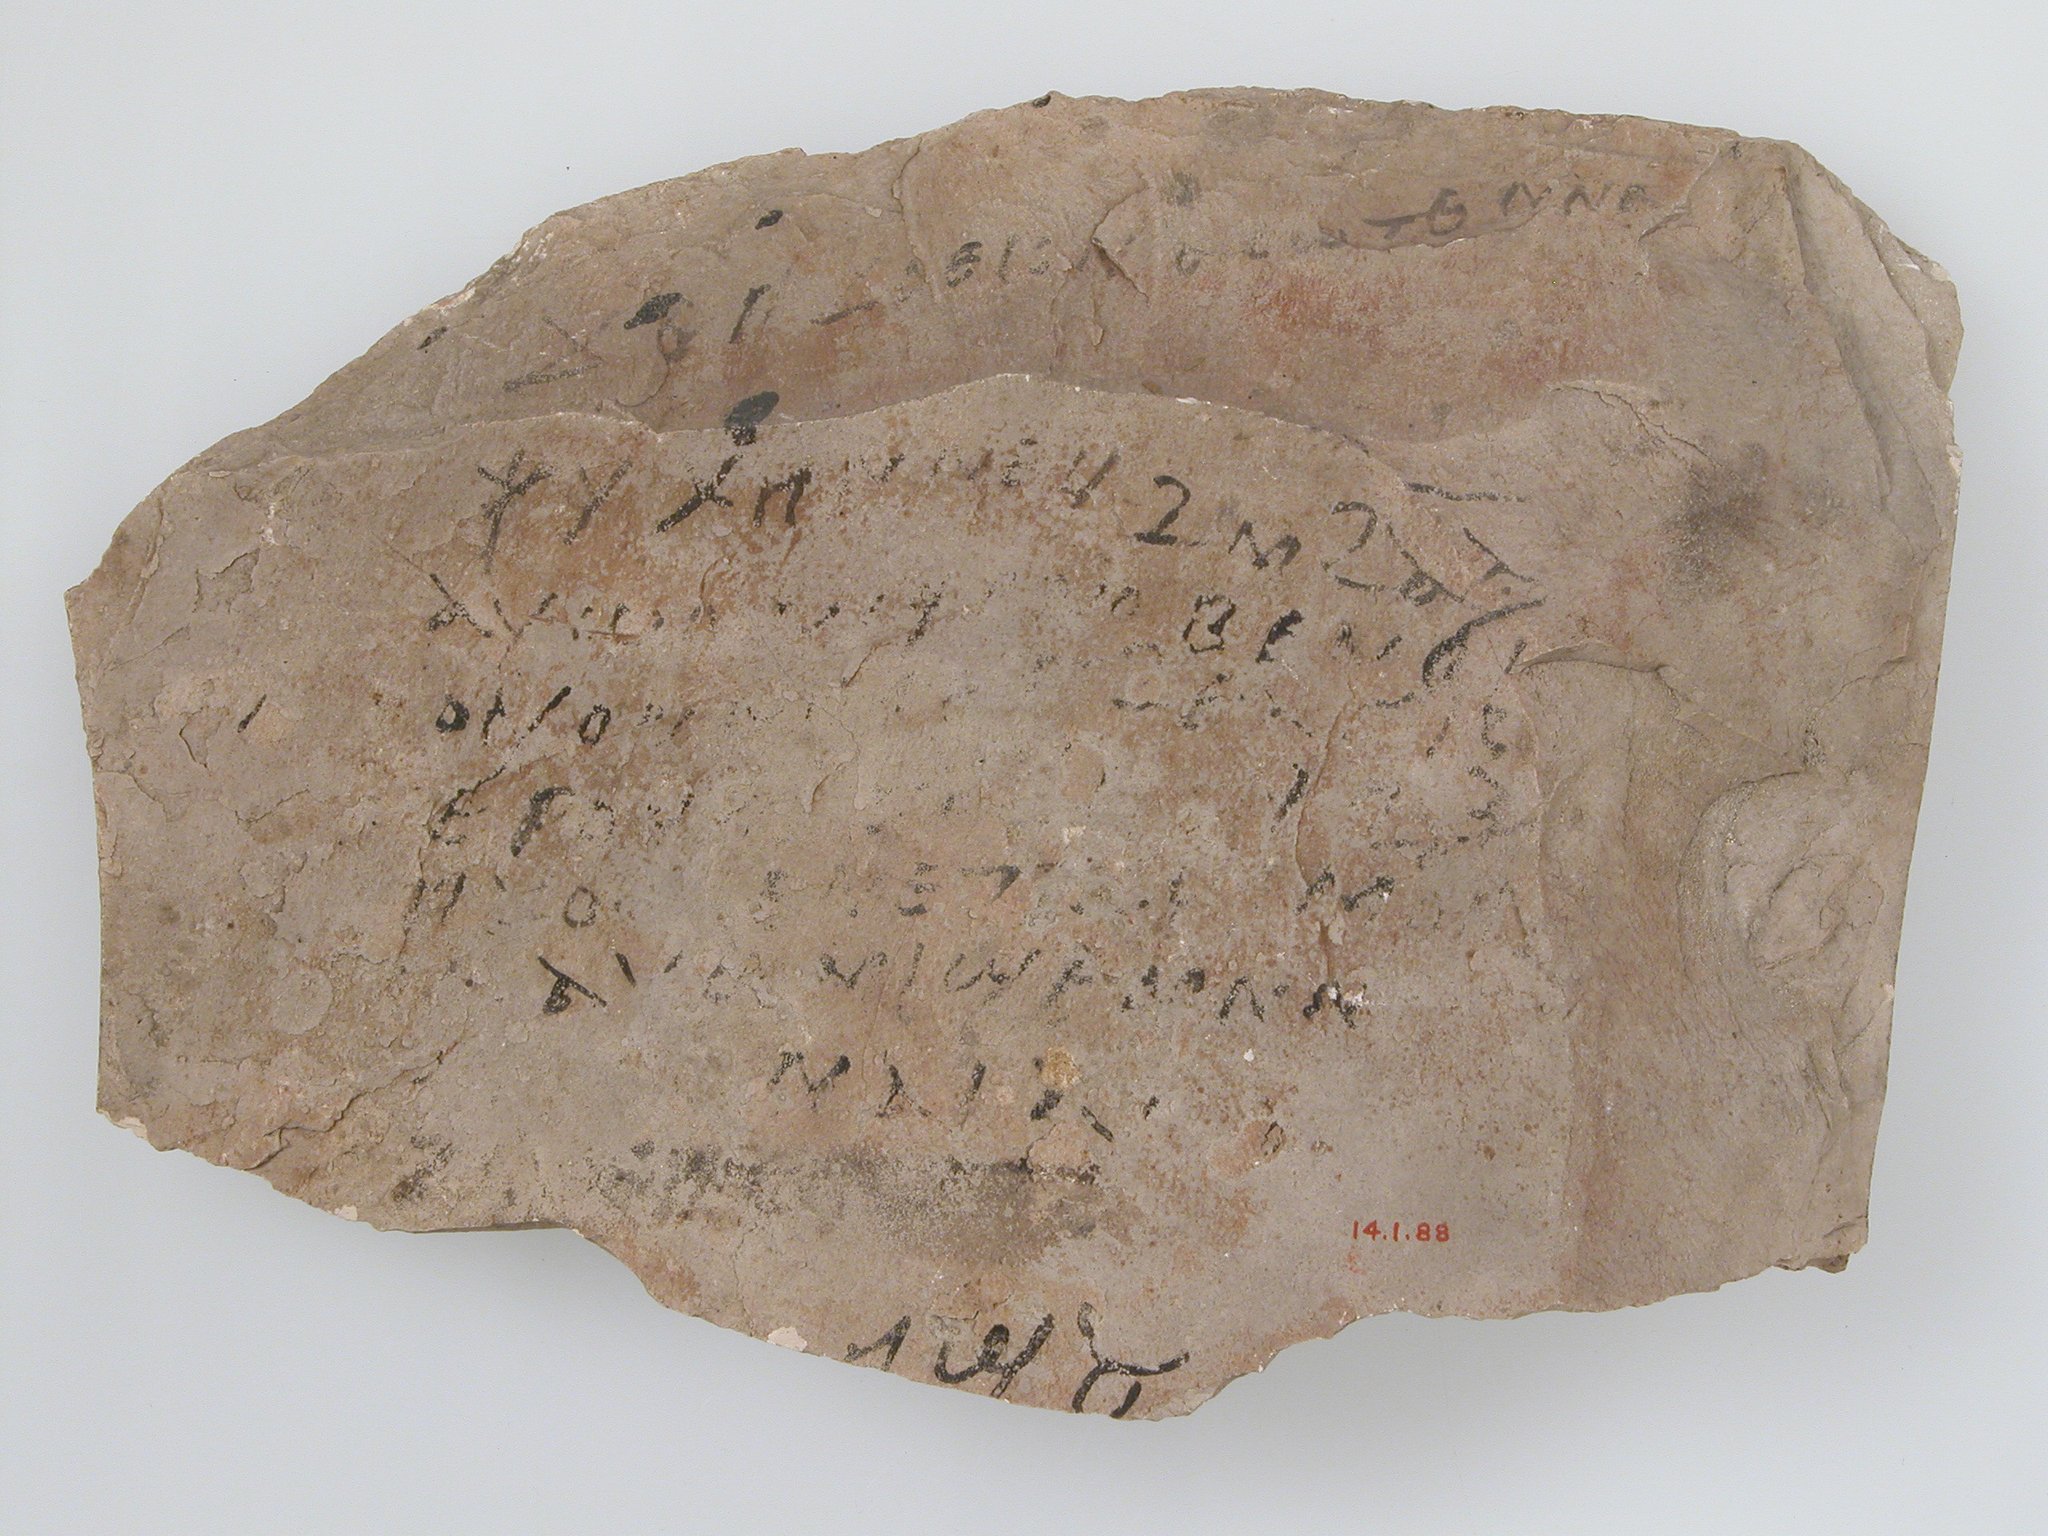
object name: ostrakon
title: Ostrakon with Biblical Text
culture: coptic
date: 600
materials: ink, limestone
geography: egypt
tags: coptic